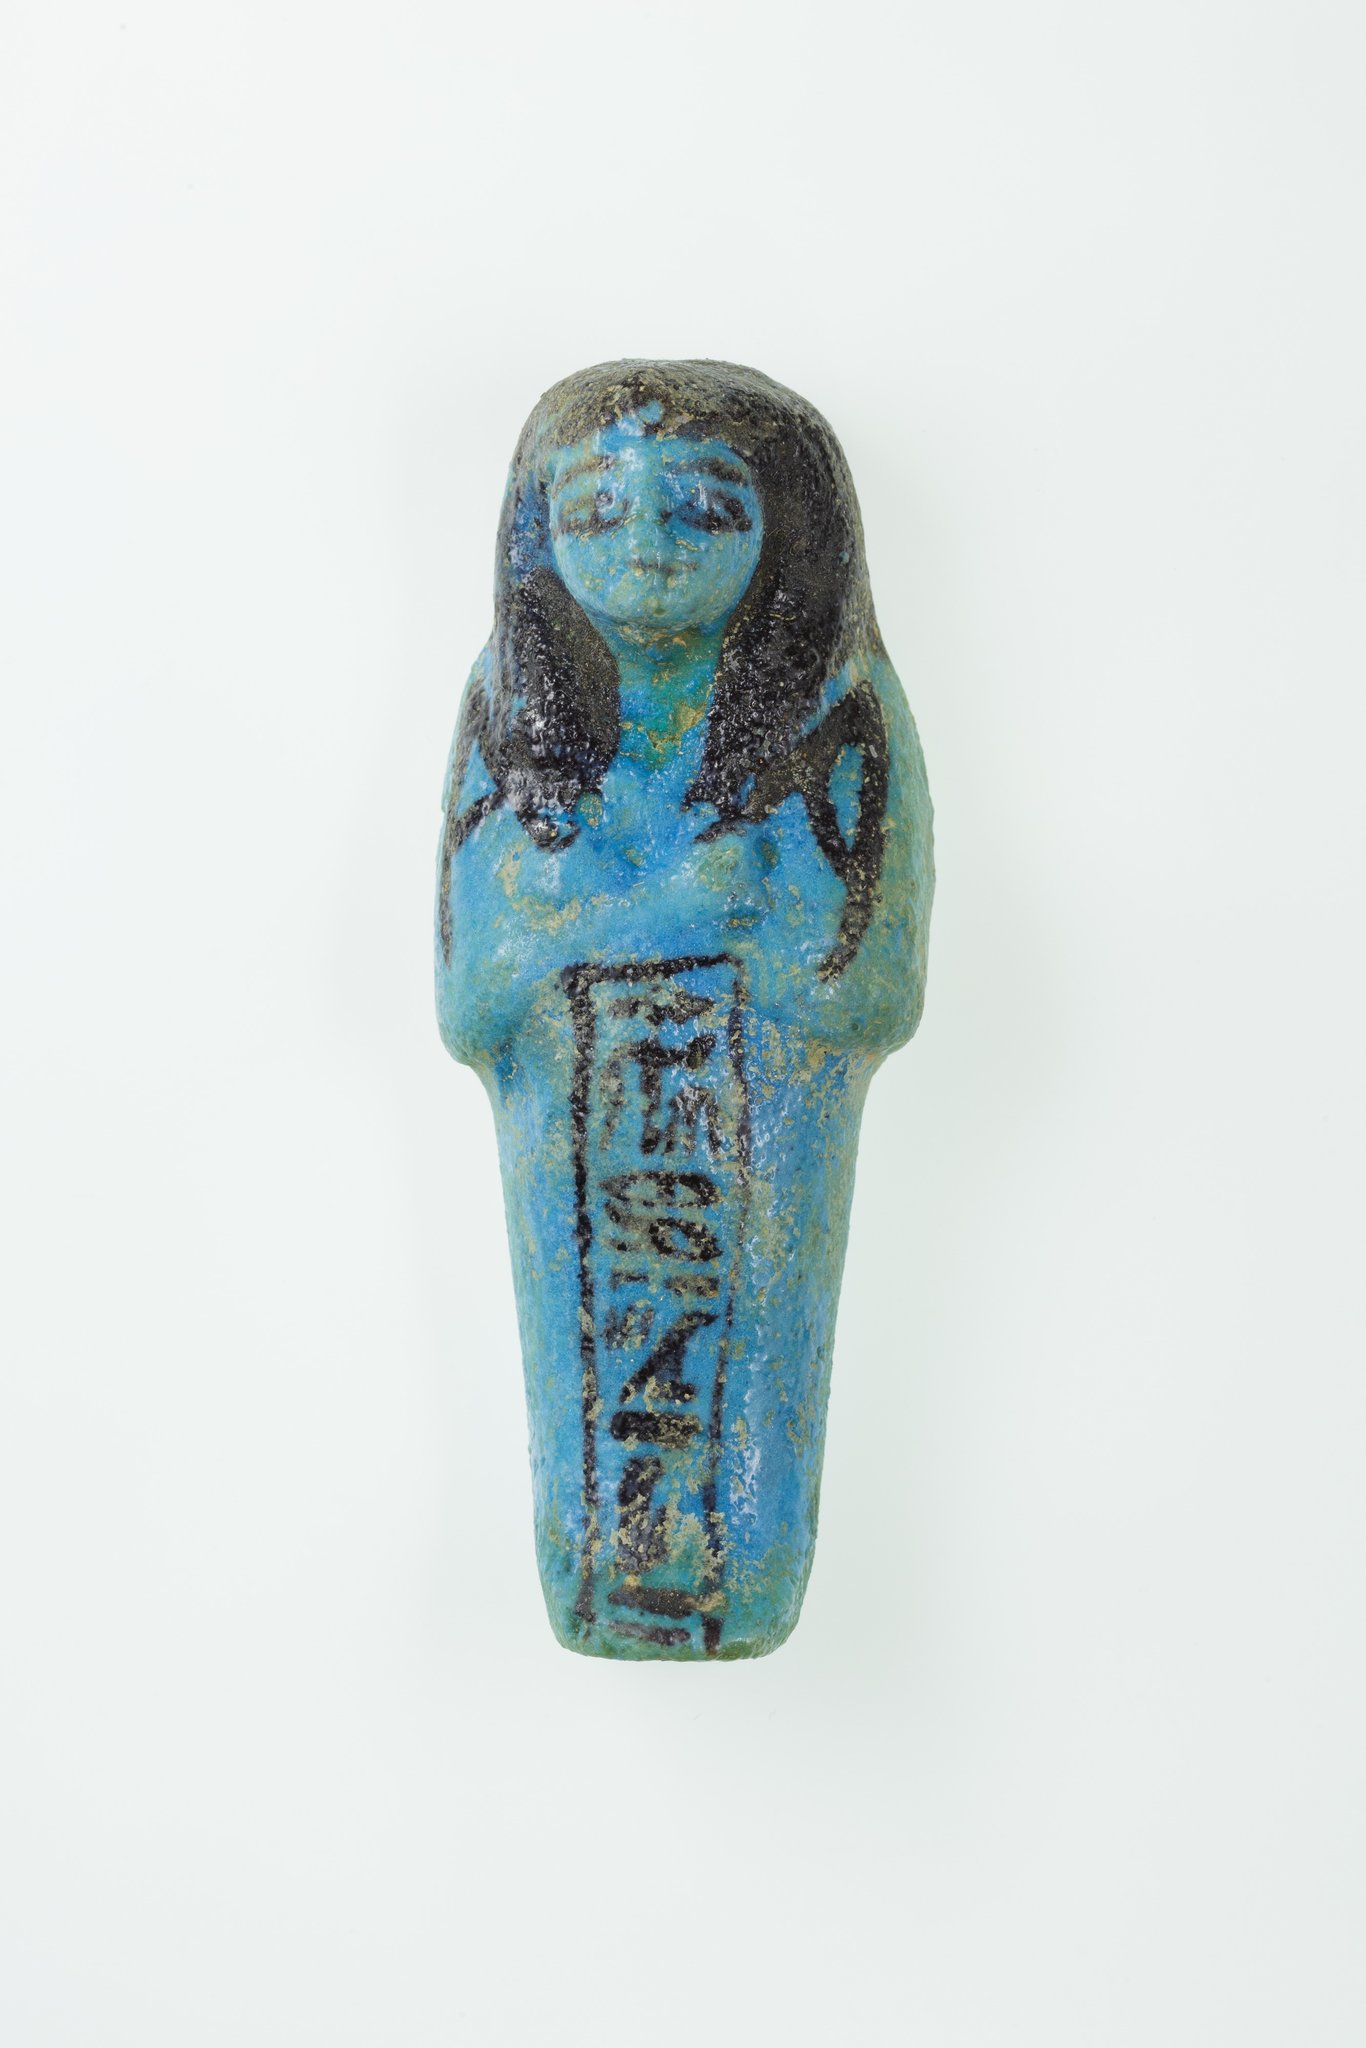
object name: shabti, worker, nauny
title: Worker Shabti of Nauny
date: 1050 BCE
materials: faience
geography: egypt